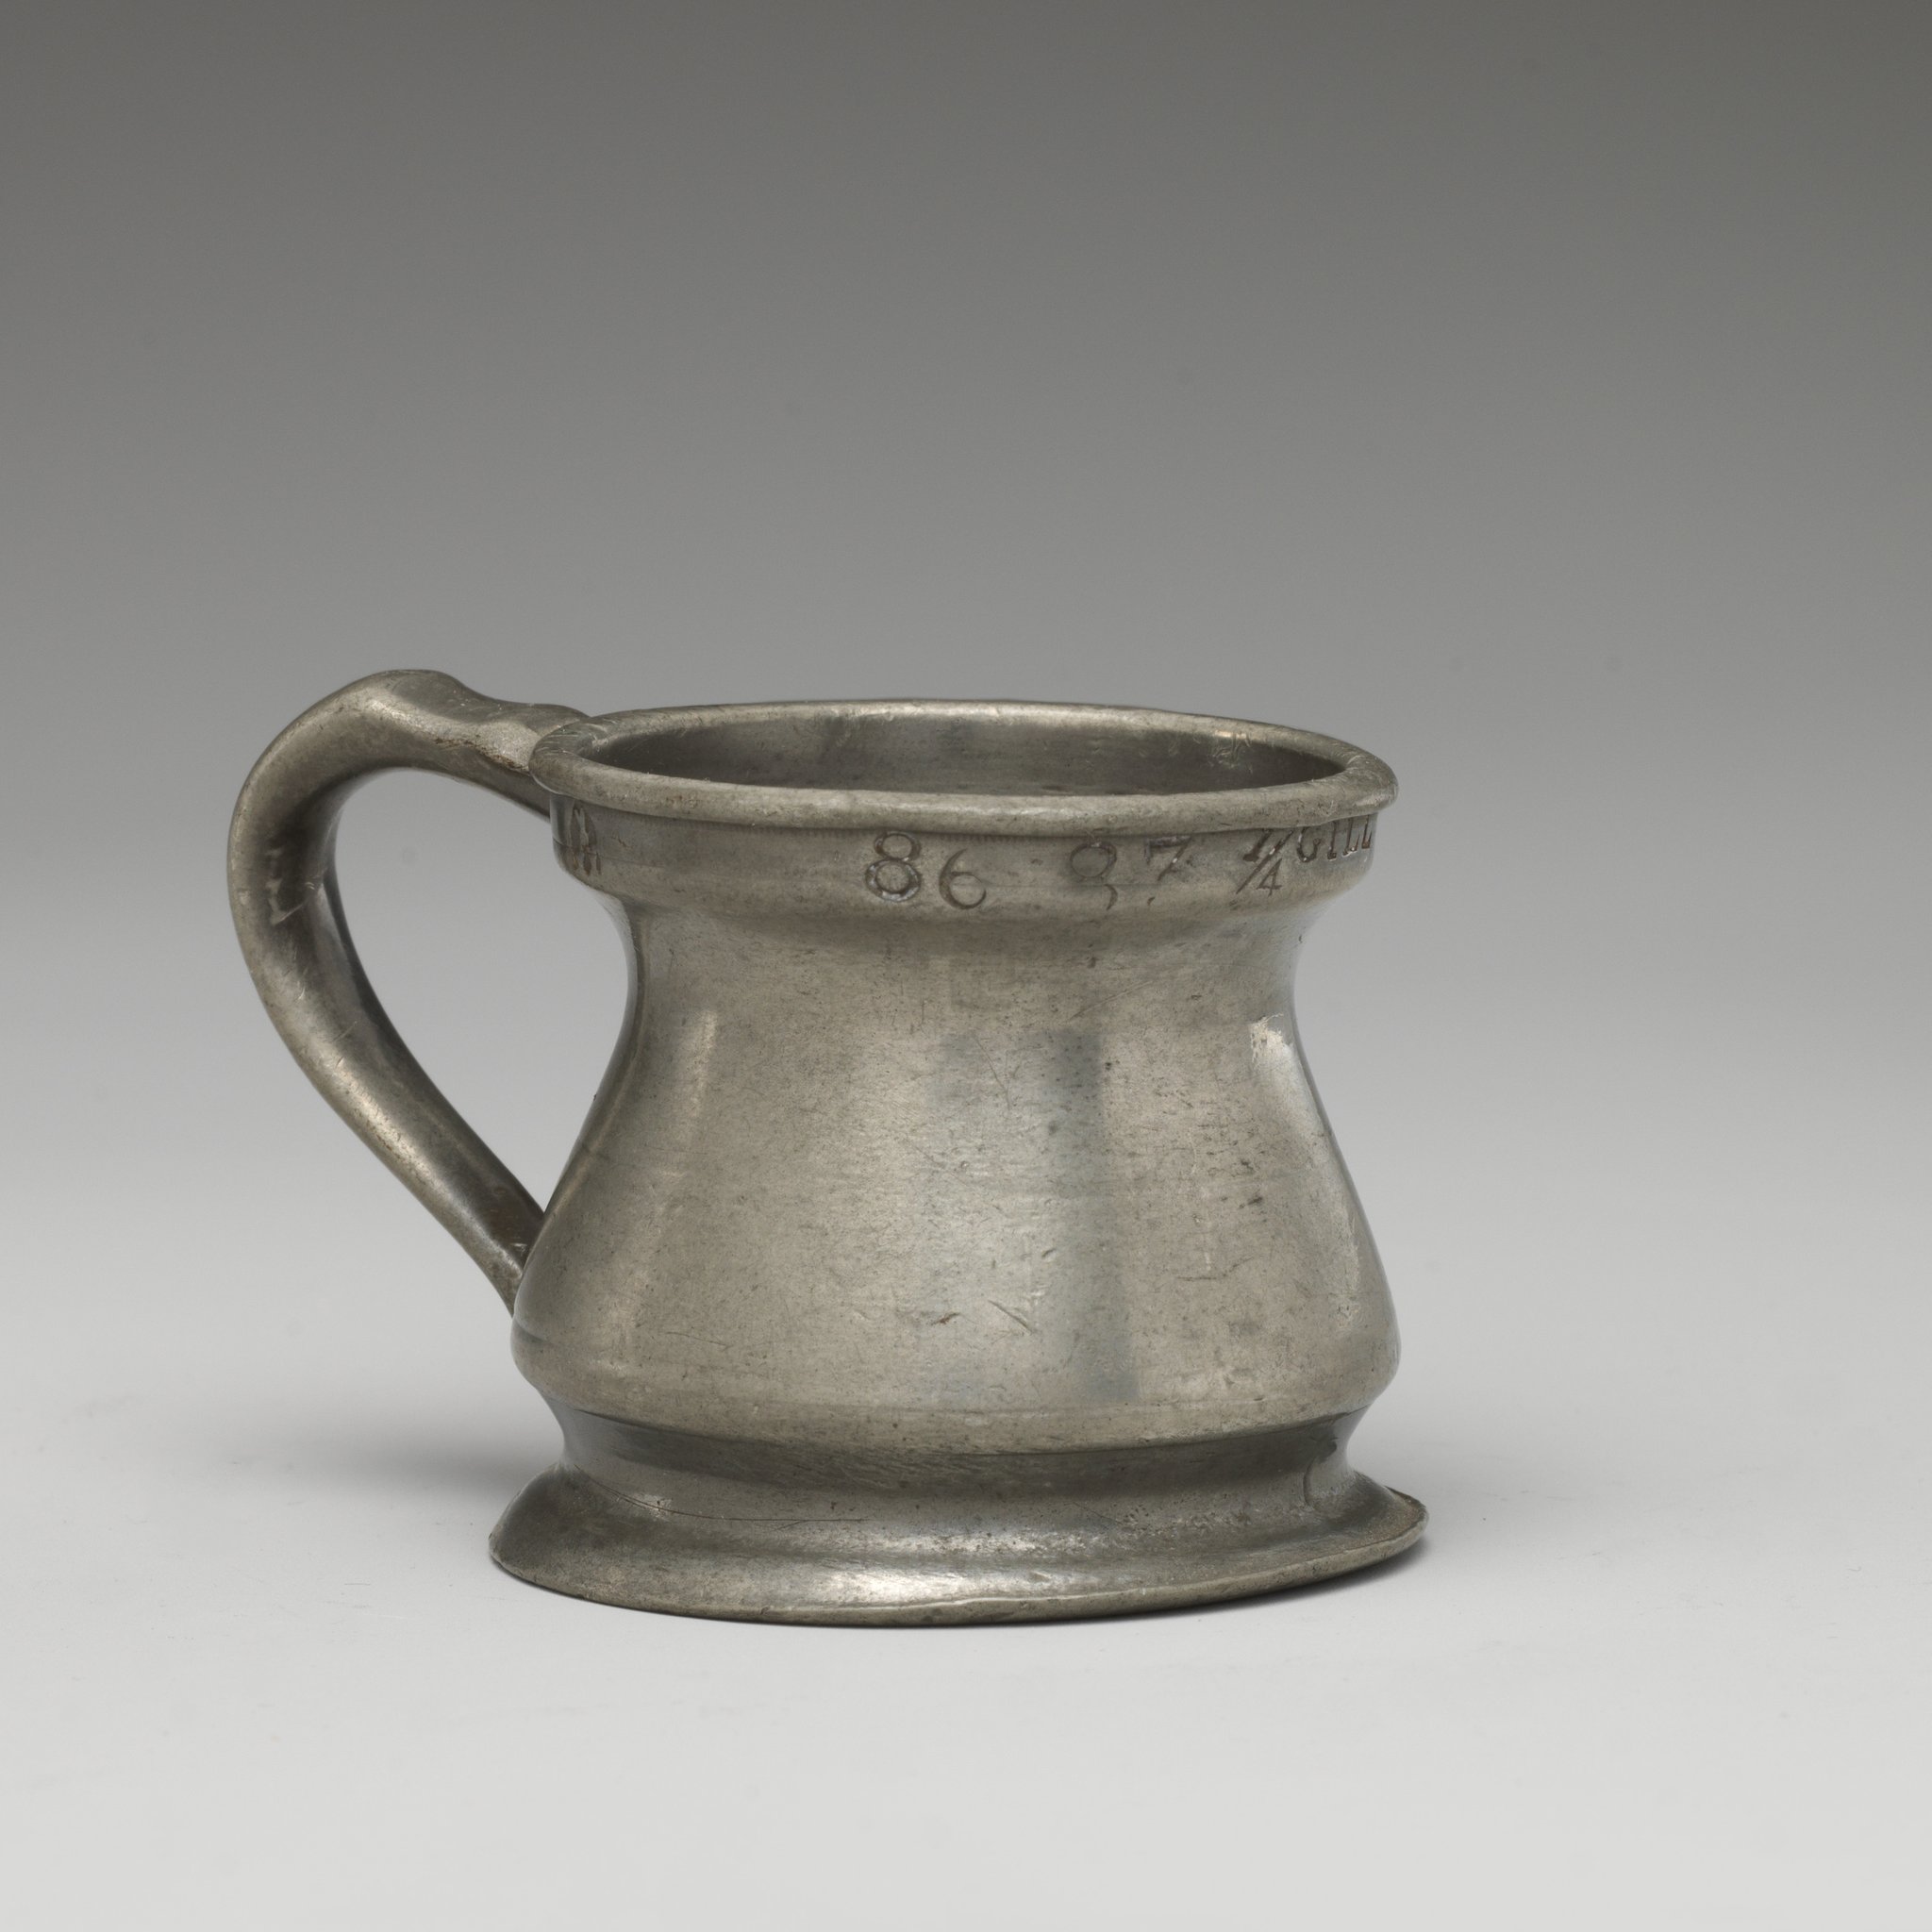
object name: measure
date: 1767-1800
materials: pewter